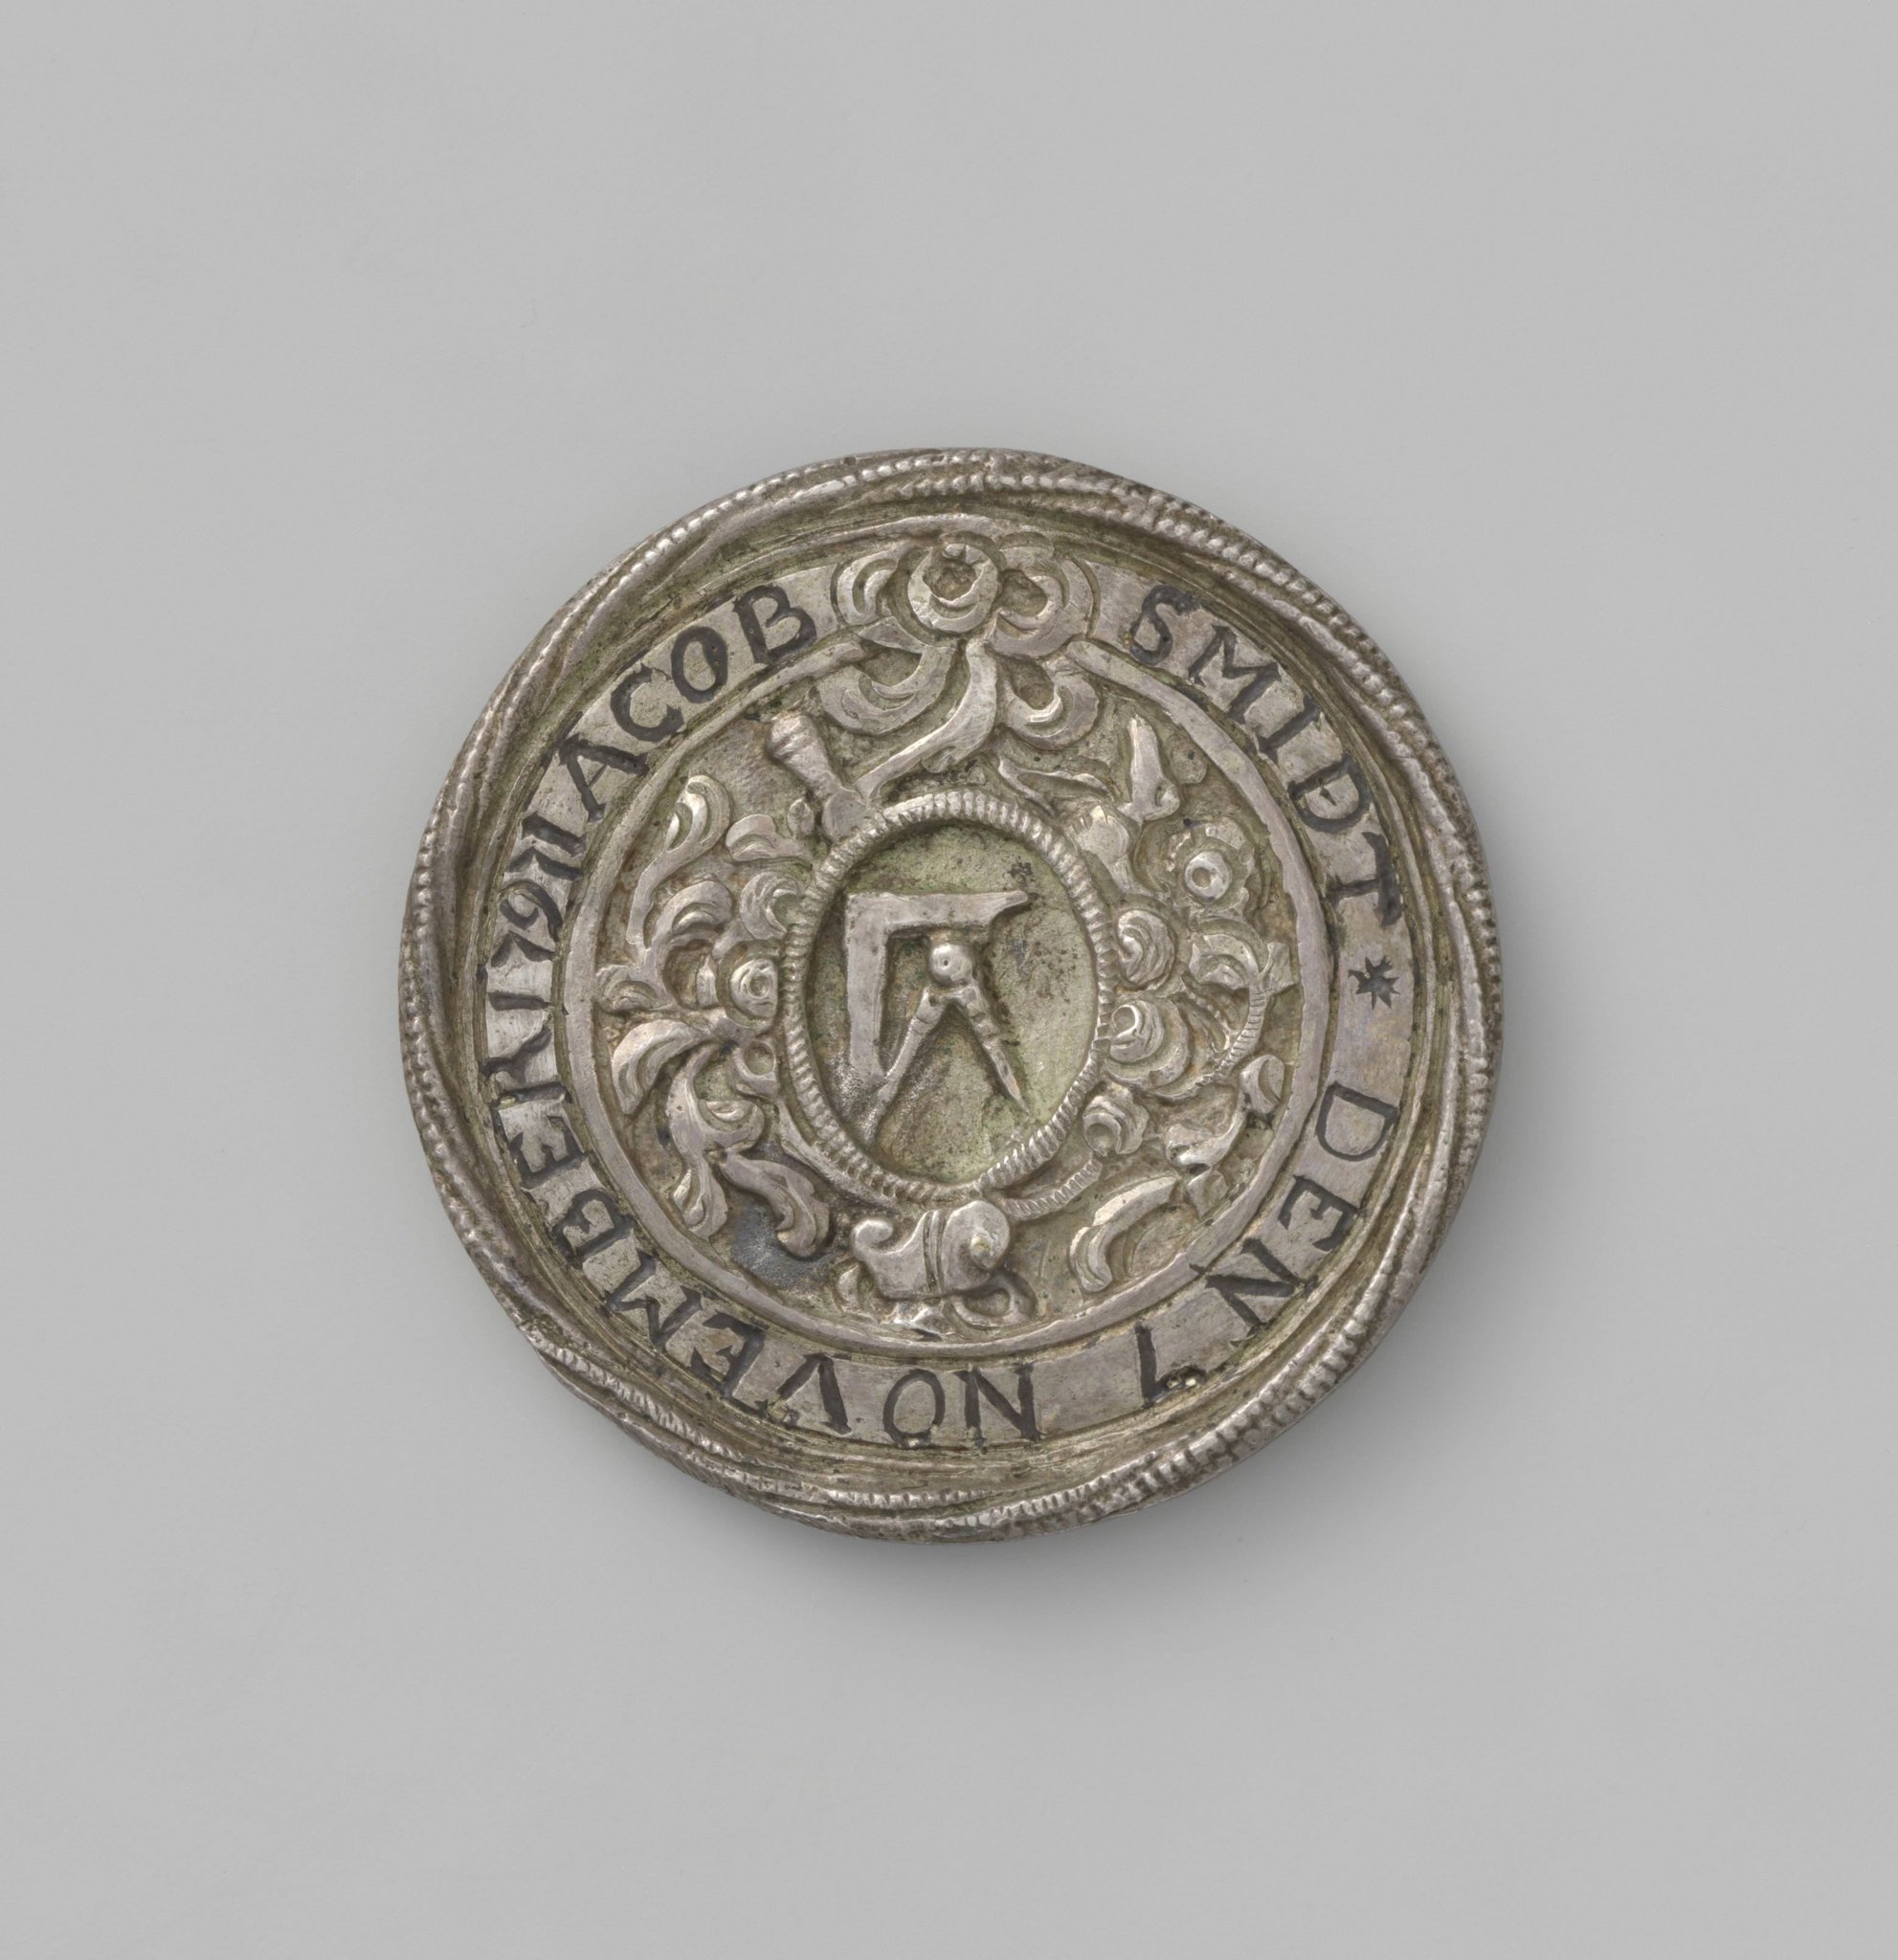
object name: medal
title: Joiners, Harlingen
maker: Anonymous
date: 1797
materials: silver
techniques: engraving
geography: harlingen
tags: harlingen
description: Guild medals Members of trade guilds had to identify themselves with a medal at their meetings.